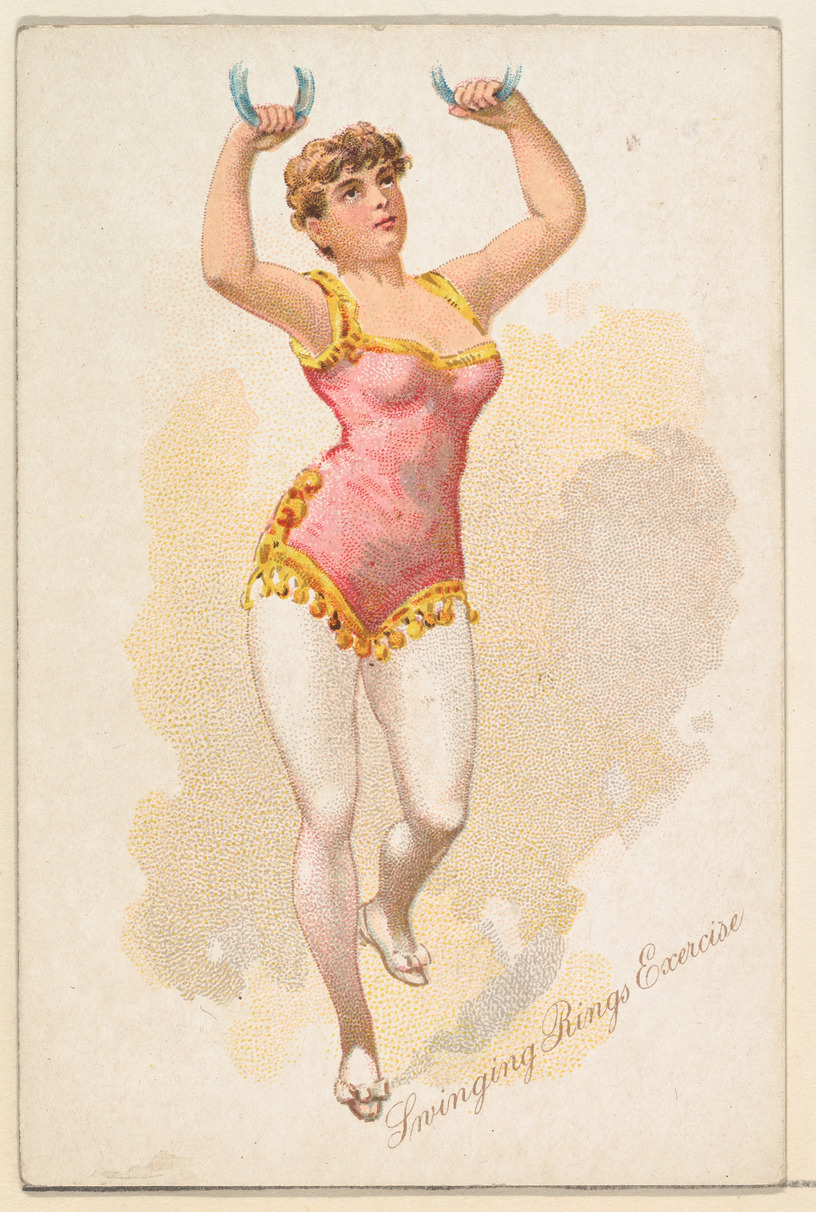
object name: print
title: Swinging Rings Exercise, from the Pretty Athletes series (N196) issued by Wm. S. Kimball & Co.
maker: william s. kimball & company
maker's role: publisher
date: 1889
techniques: color lithograph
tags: women,athletes